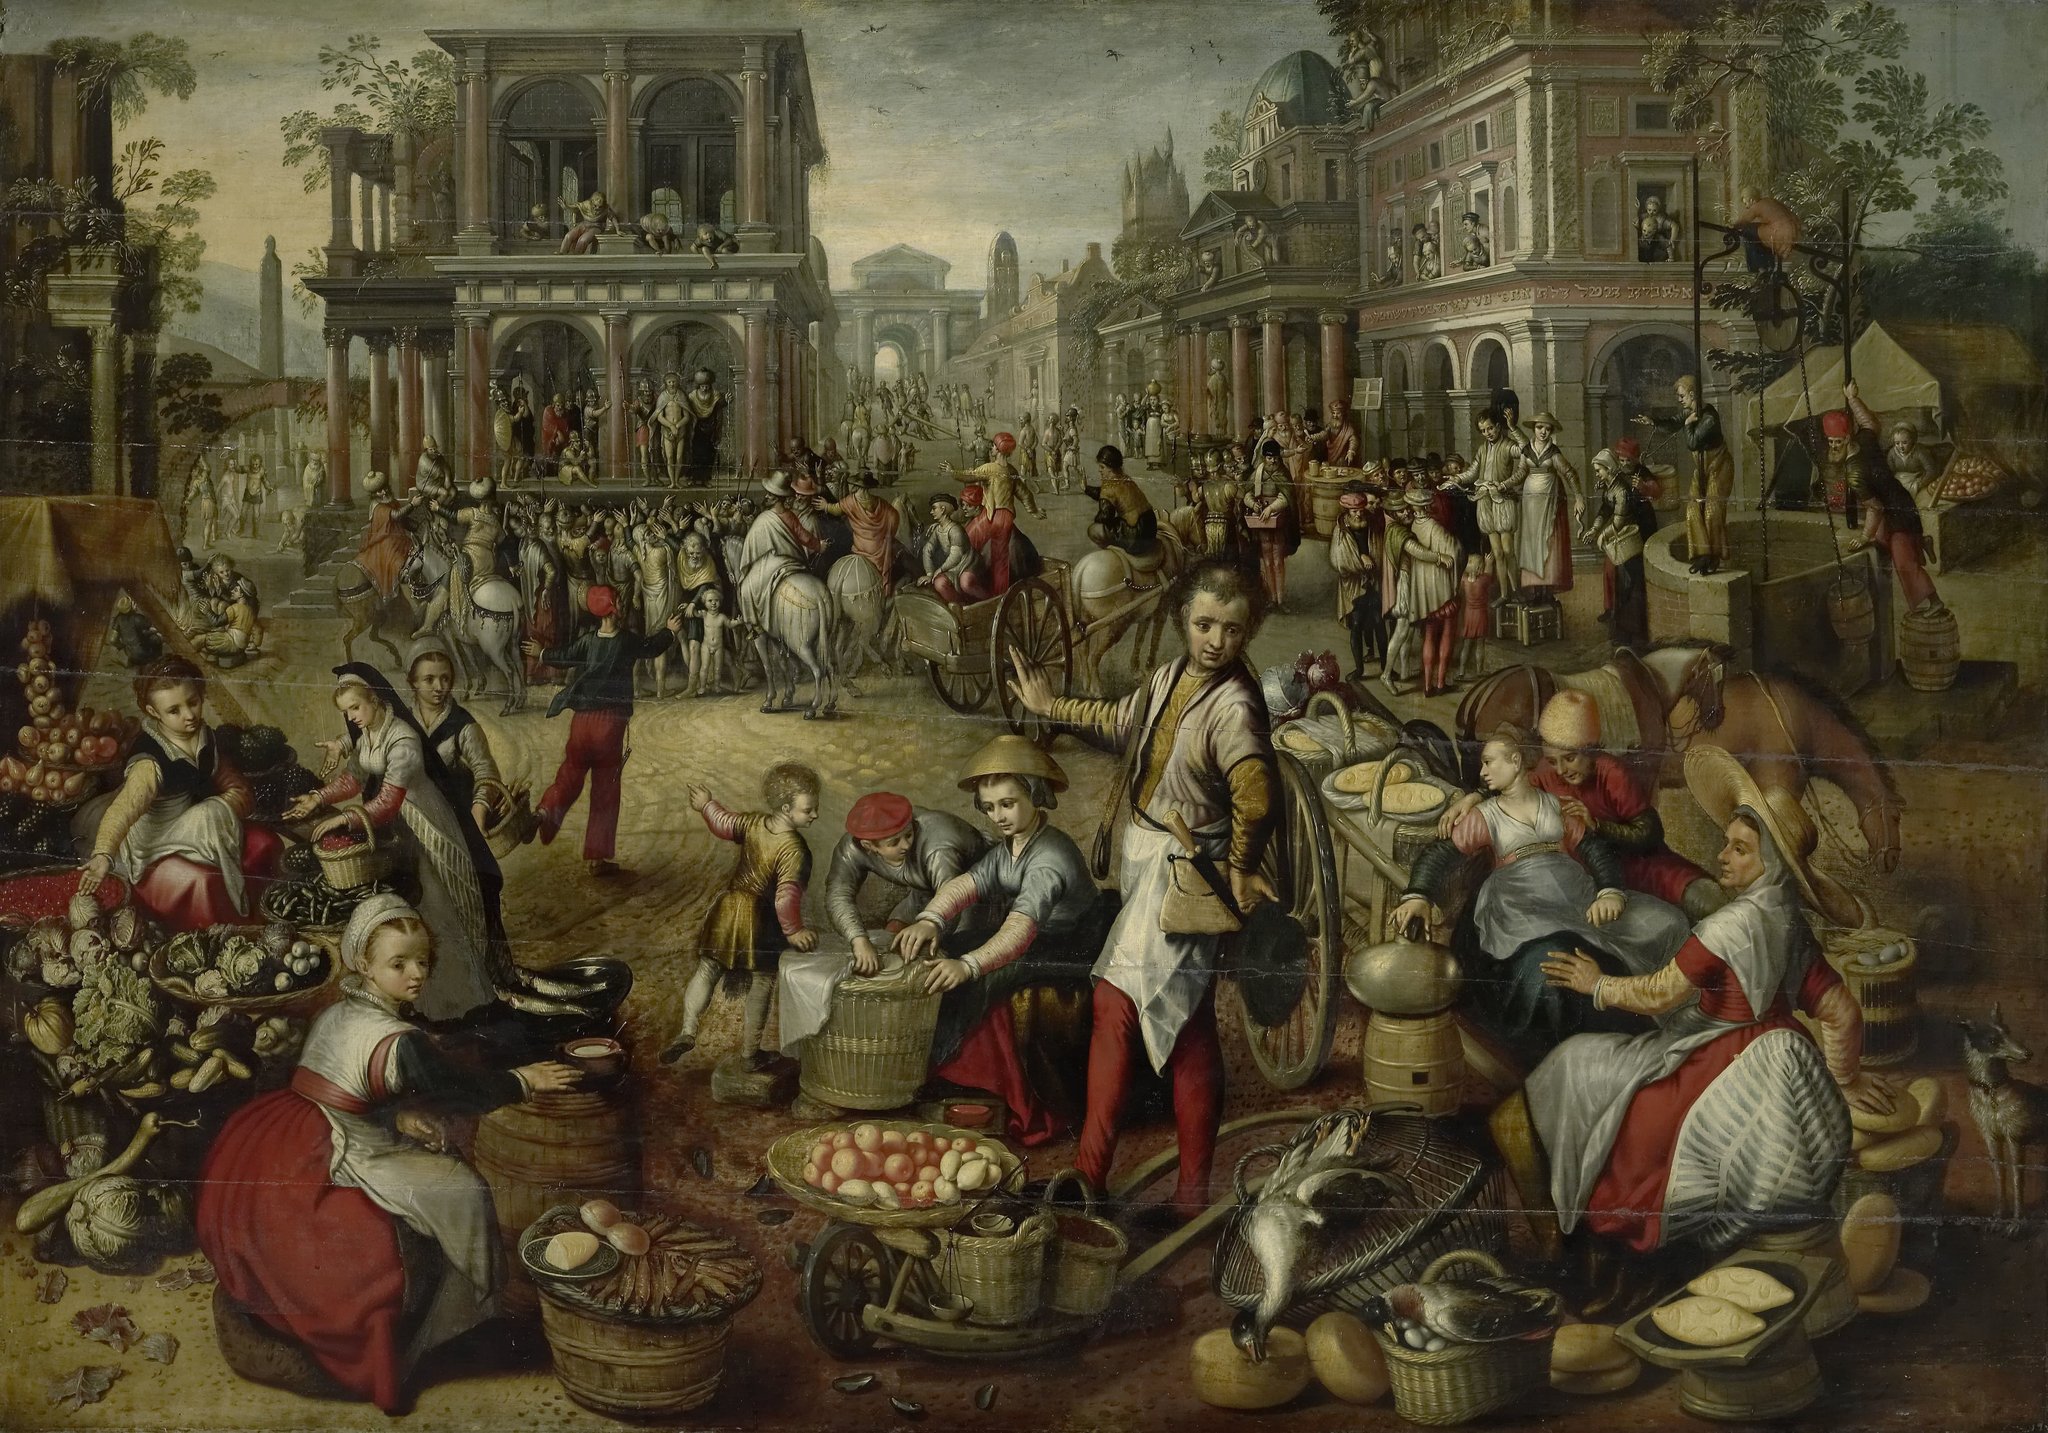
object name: painting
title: Marketplace, with the Flagellation, the Ecce Homo and the Bearing of the Cross in the background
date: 1550-1590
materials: oil, panel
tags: christ alone (also called 'ecce homo'), market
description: Marktplein met op de achtergrond scènes uit de passie van Christus: de geseling, Ecce homo en de kruisdraging. Op de voorgrond bieden marktkooplui hun waar aan: groente, vis, fruit, brood, gevogelte en kaas. Rechts bij een waterput andere verkopers bij hun stalletjes. Voorheen beschouwd als eigenhandig. Betere versies in Moskou en Baton Rouge.